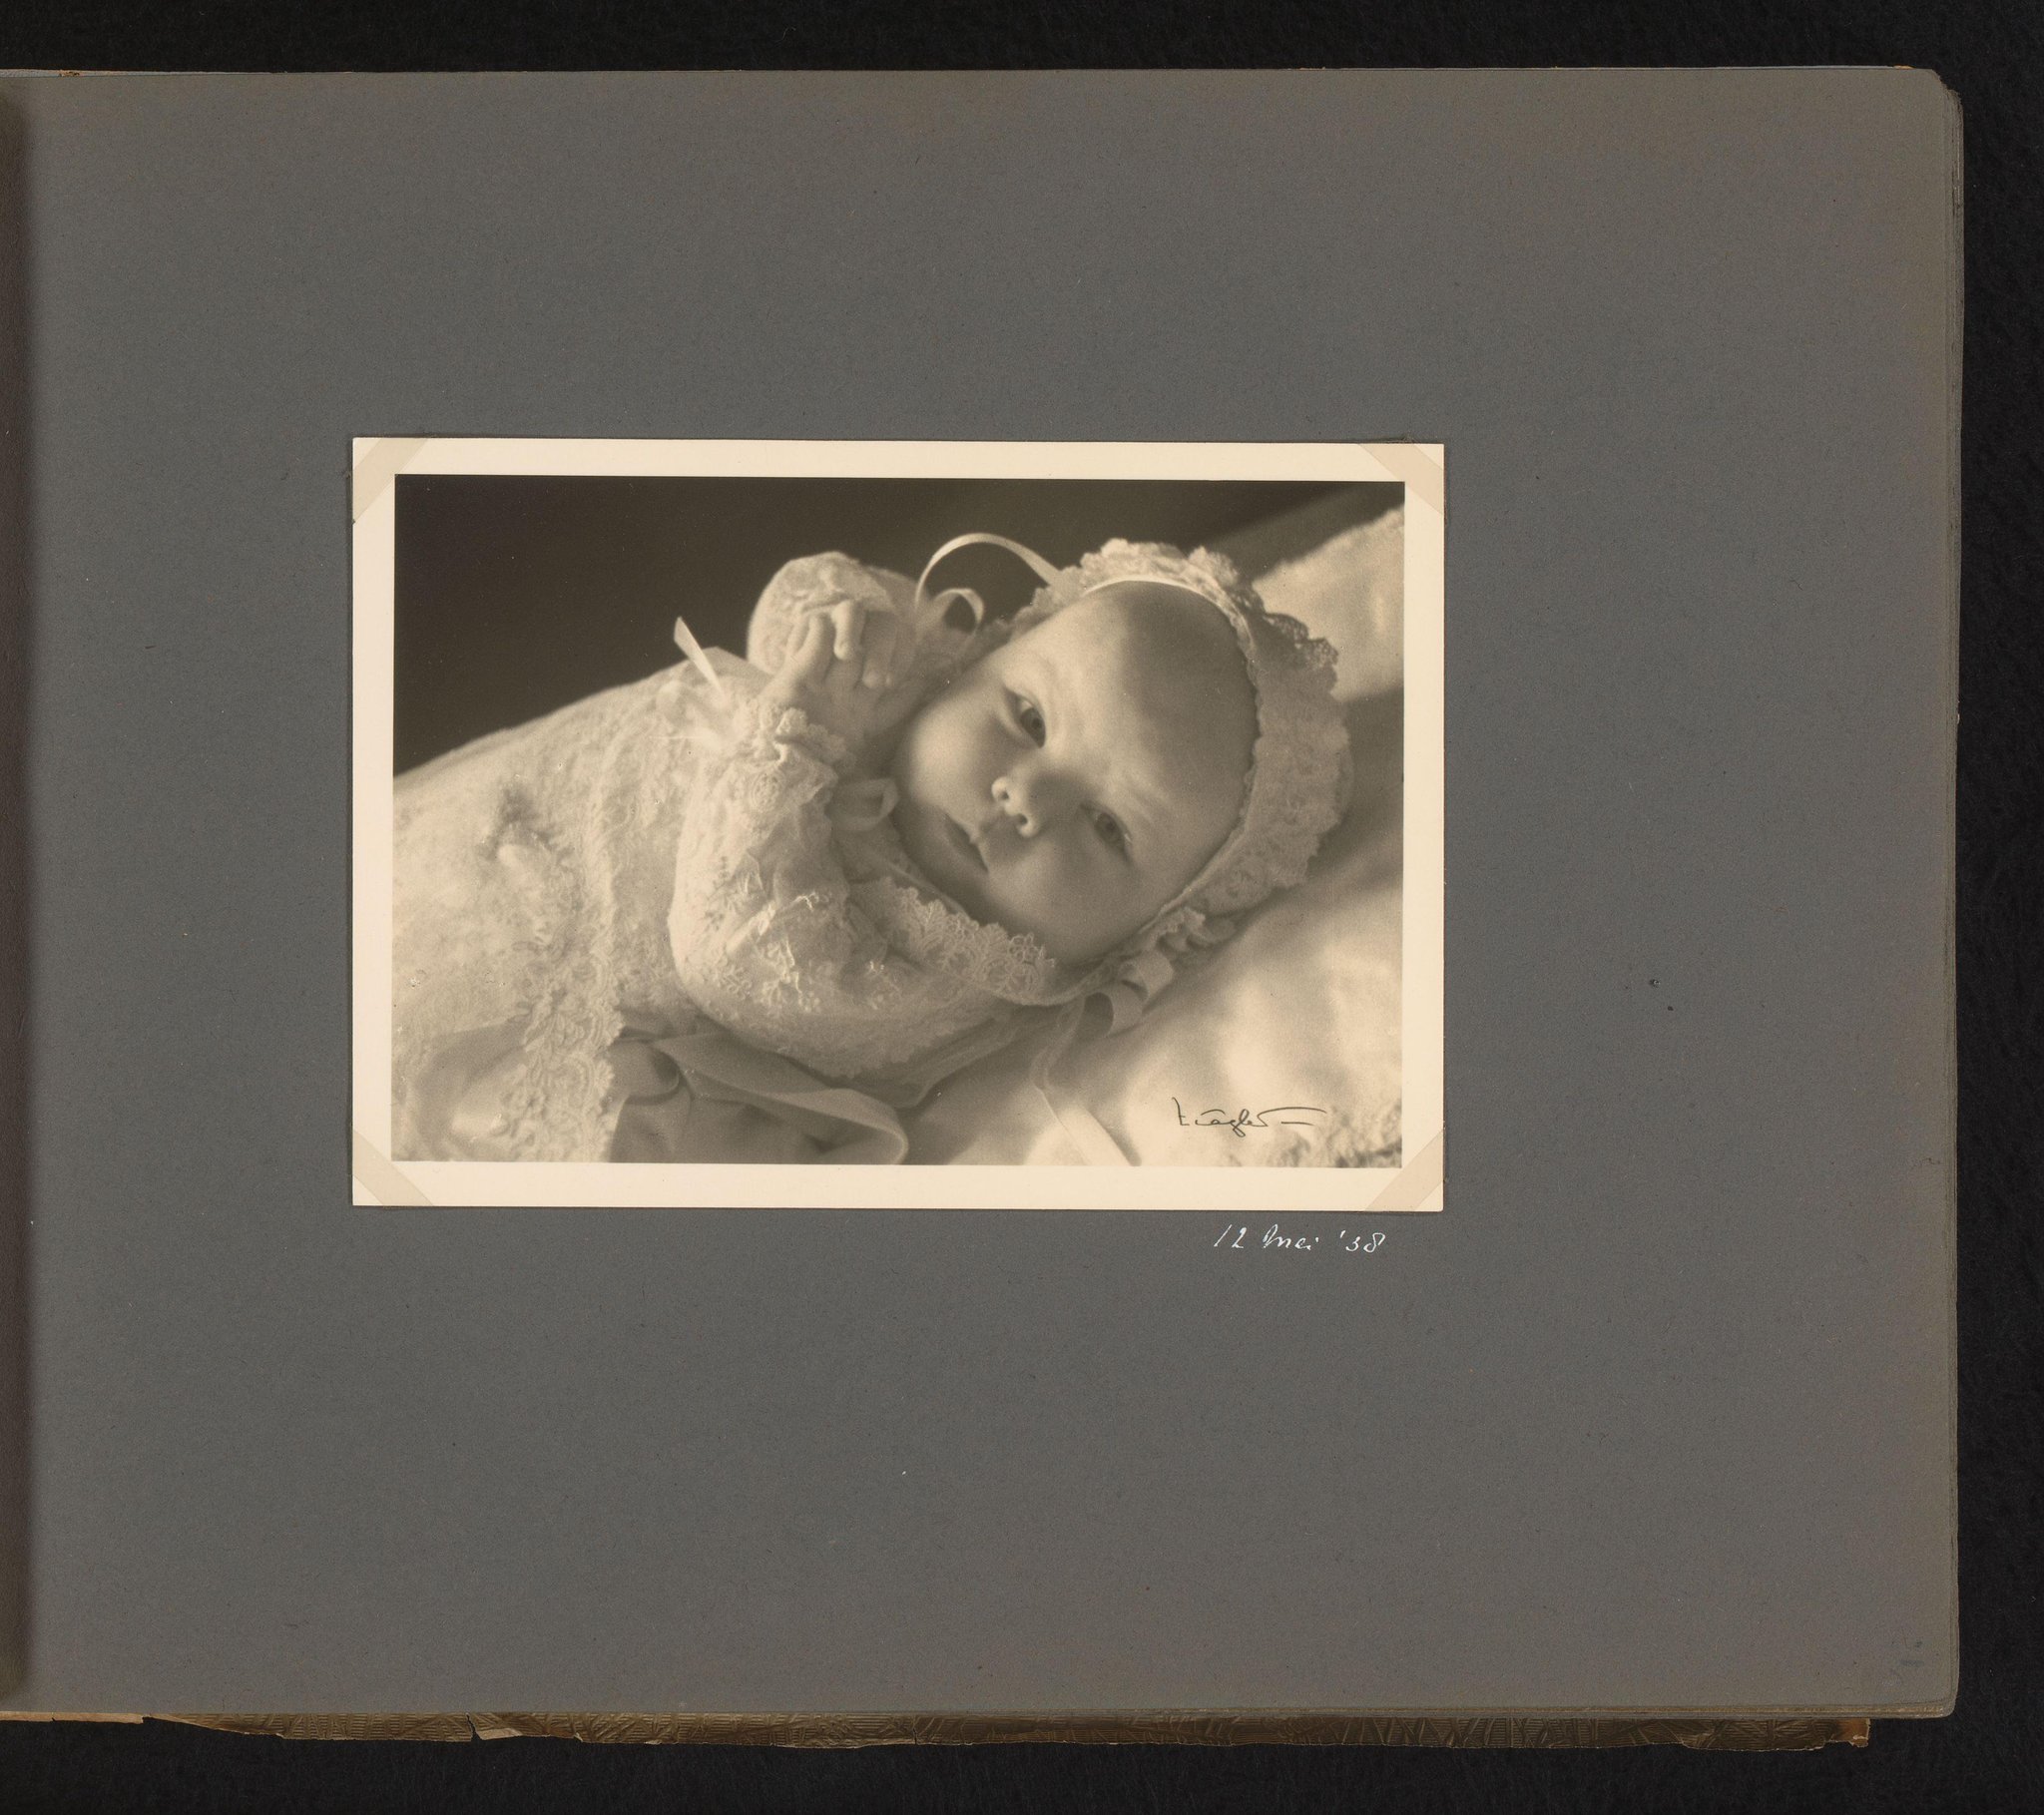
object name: photograph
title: Prinses Beatrix 12 Mei 1938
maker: franz ziegler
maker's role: fotograaf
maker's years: 1893-1939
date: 1905-1938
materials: cardboard, photographic support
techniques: gelatin silver print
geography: the hague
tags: beatrix (koningin der nederlanden), baptism ~ protestant service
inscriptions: number: ‘1788’, date: ‘12 mei '38’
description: Albumblad met een foto van prinses Beatrix, bij de doop op 12 mei 1938. Onderdeel van fotoalbum over het familieleven van de leden van het Koninklijk Huis tussen 1937-1945.